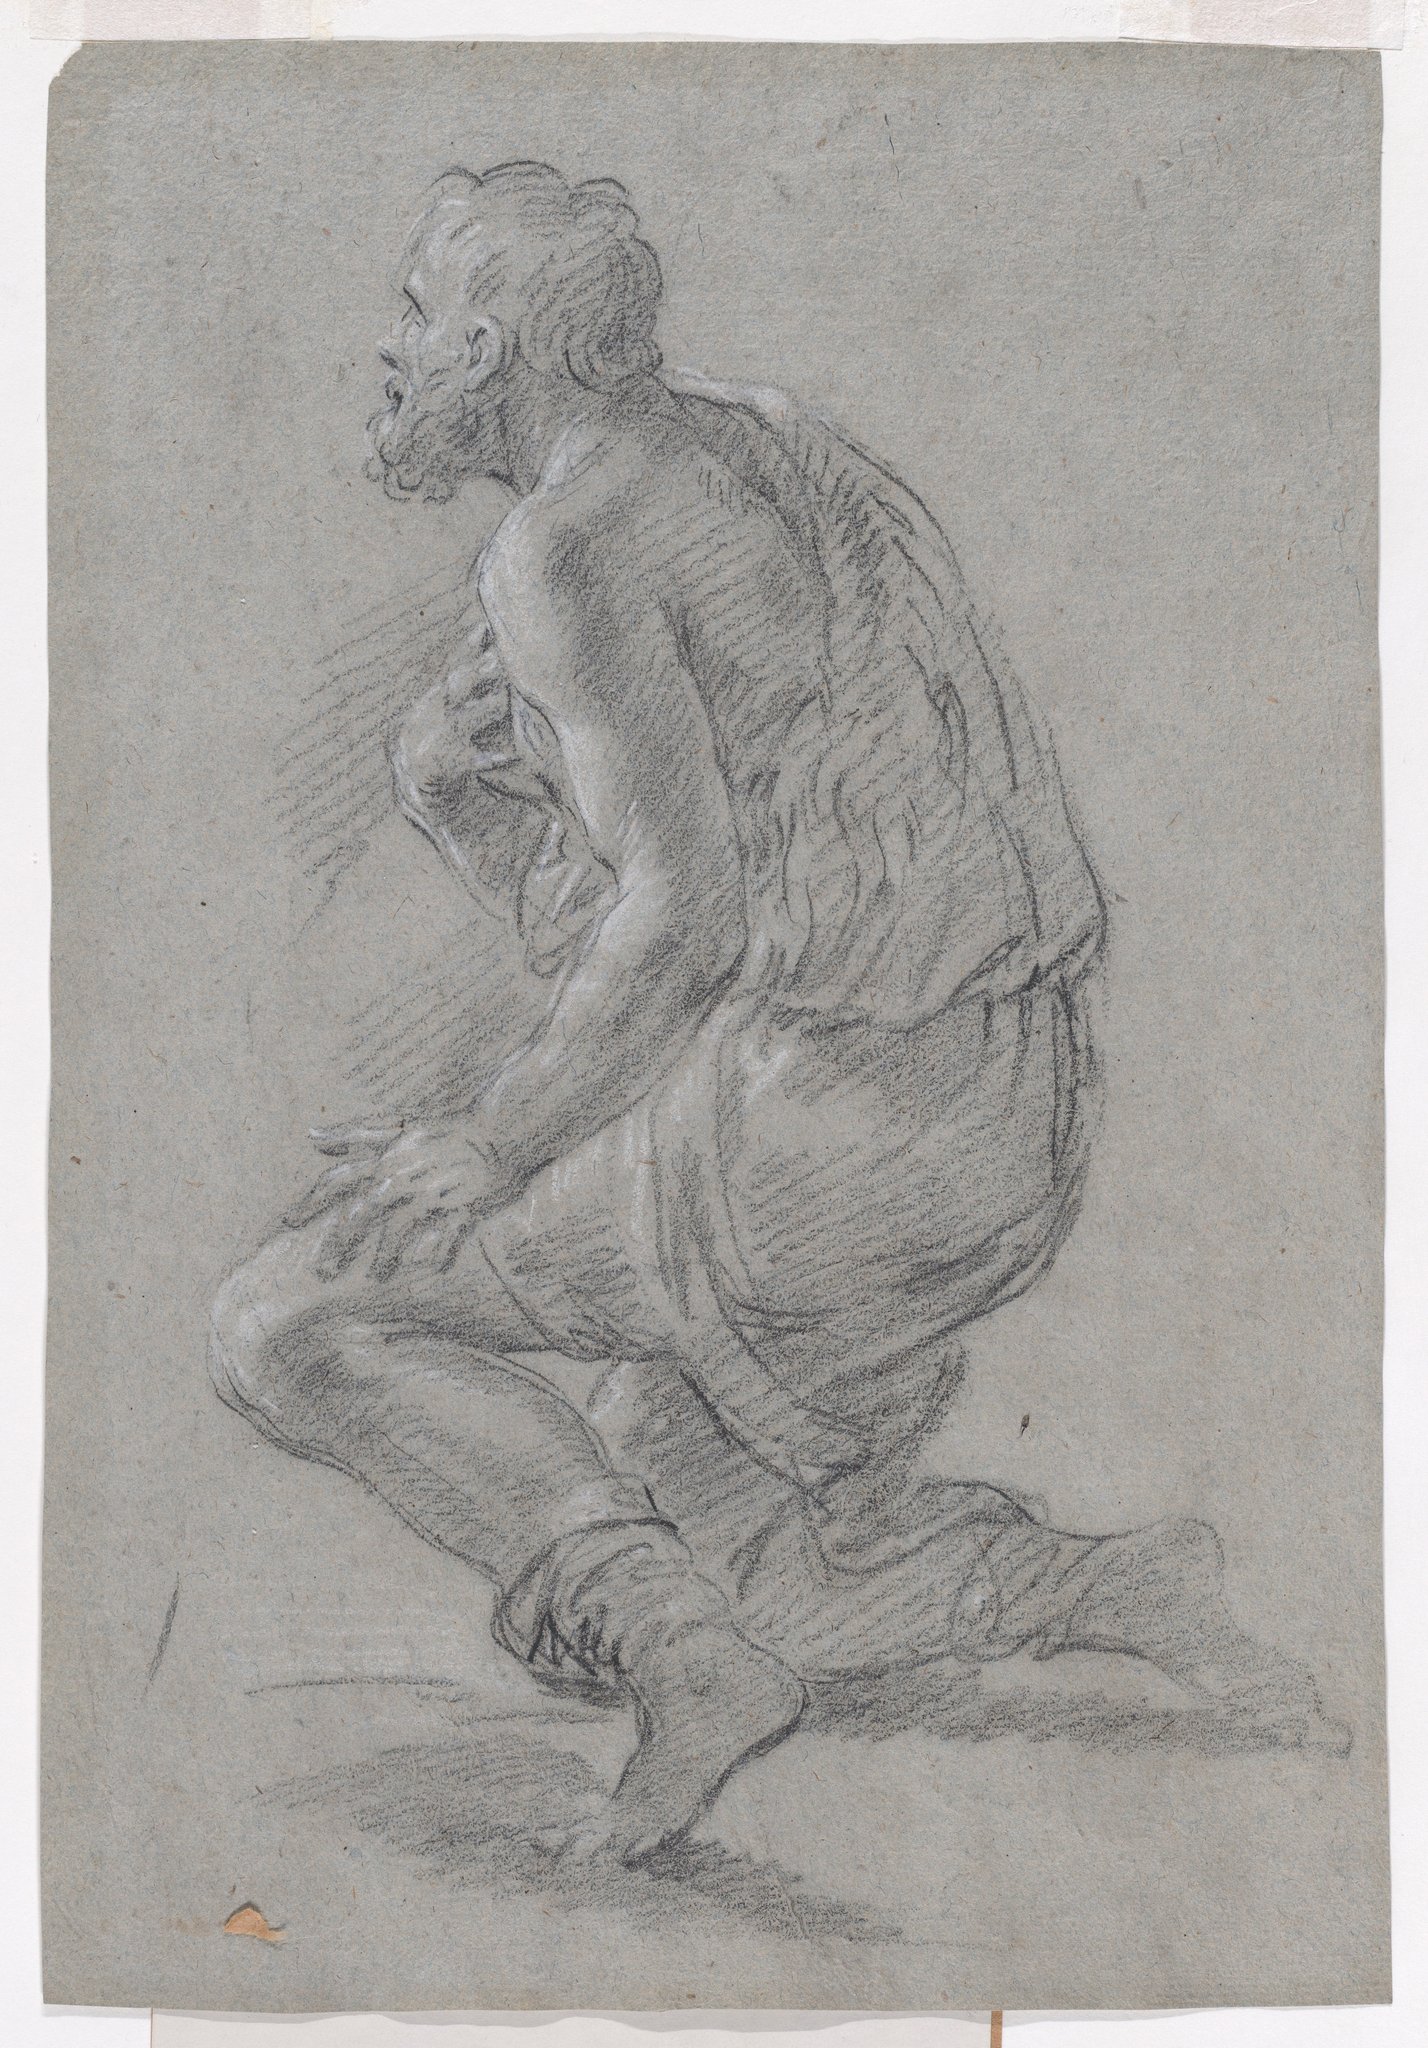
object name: drawing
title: Study of Male Figure Kneeling in a Three-Quarter View, Facing Left (a Shepherd)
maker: giacomo zoboli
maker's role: artist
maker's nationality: italian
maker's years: 1681-1767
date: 1701-1800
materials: chalk, paper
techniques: highlighting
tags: men